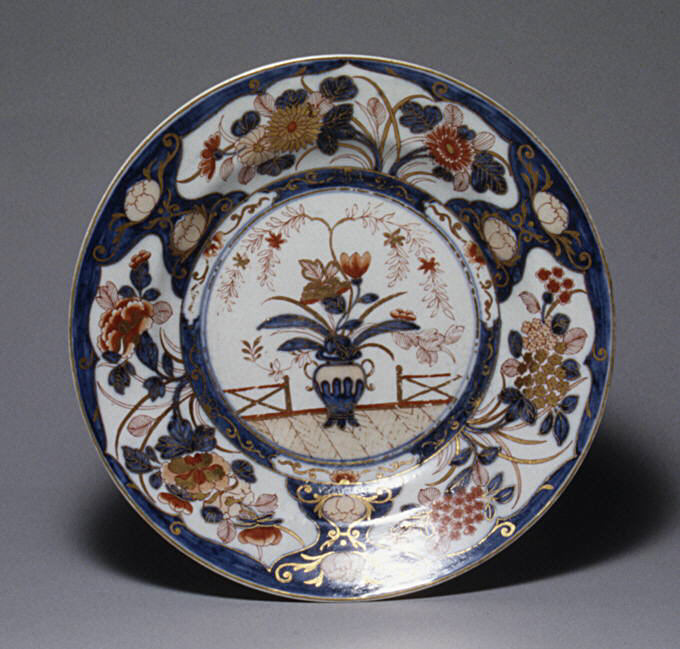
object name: plate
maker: imperial porcelain manufactory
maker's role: manufactory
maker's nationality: austrian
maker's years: 1744-1864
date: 1744-1749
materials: hard paste porcelain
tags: flowers